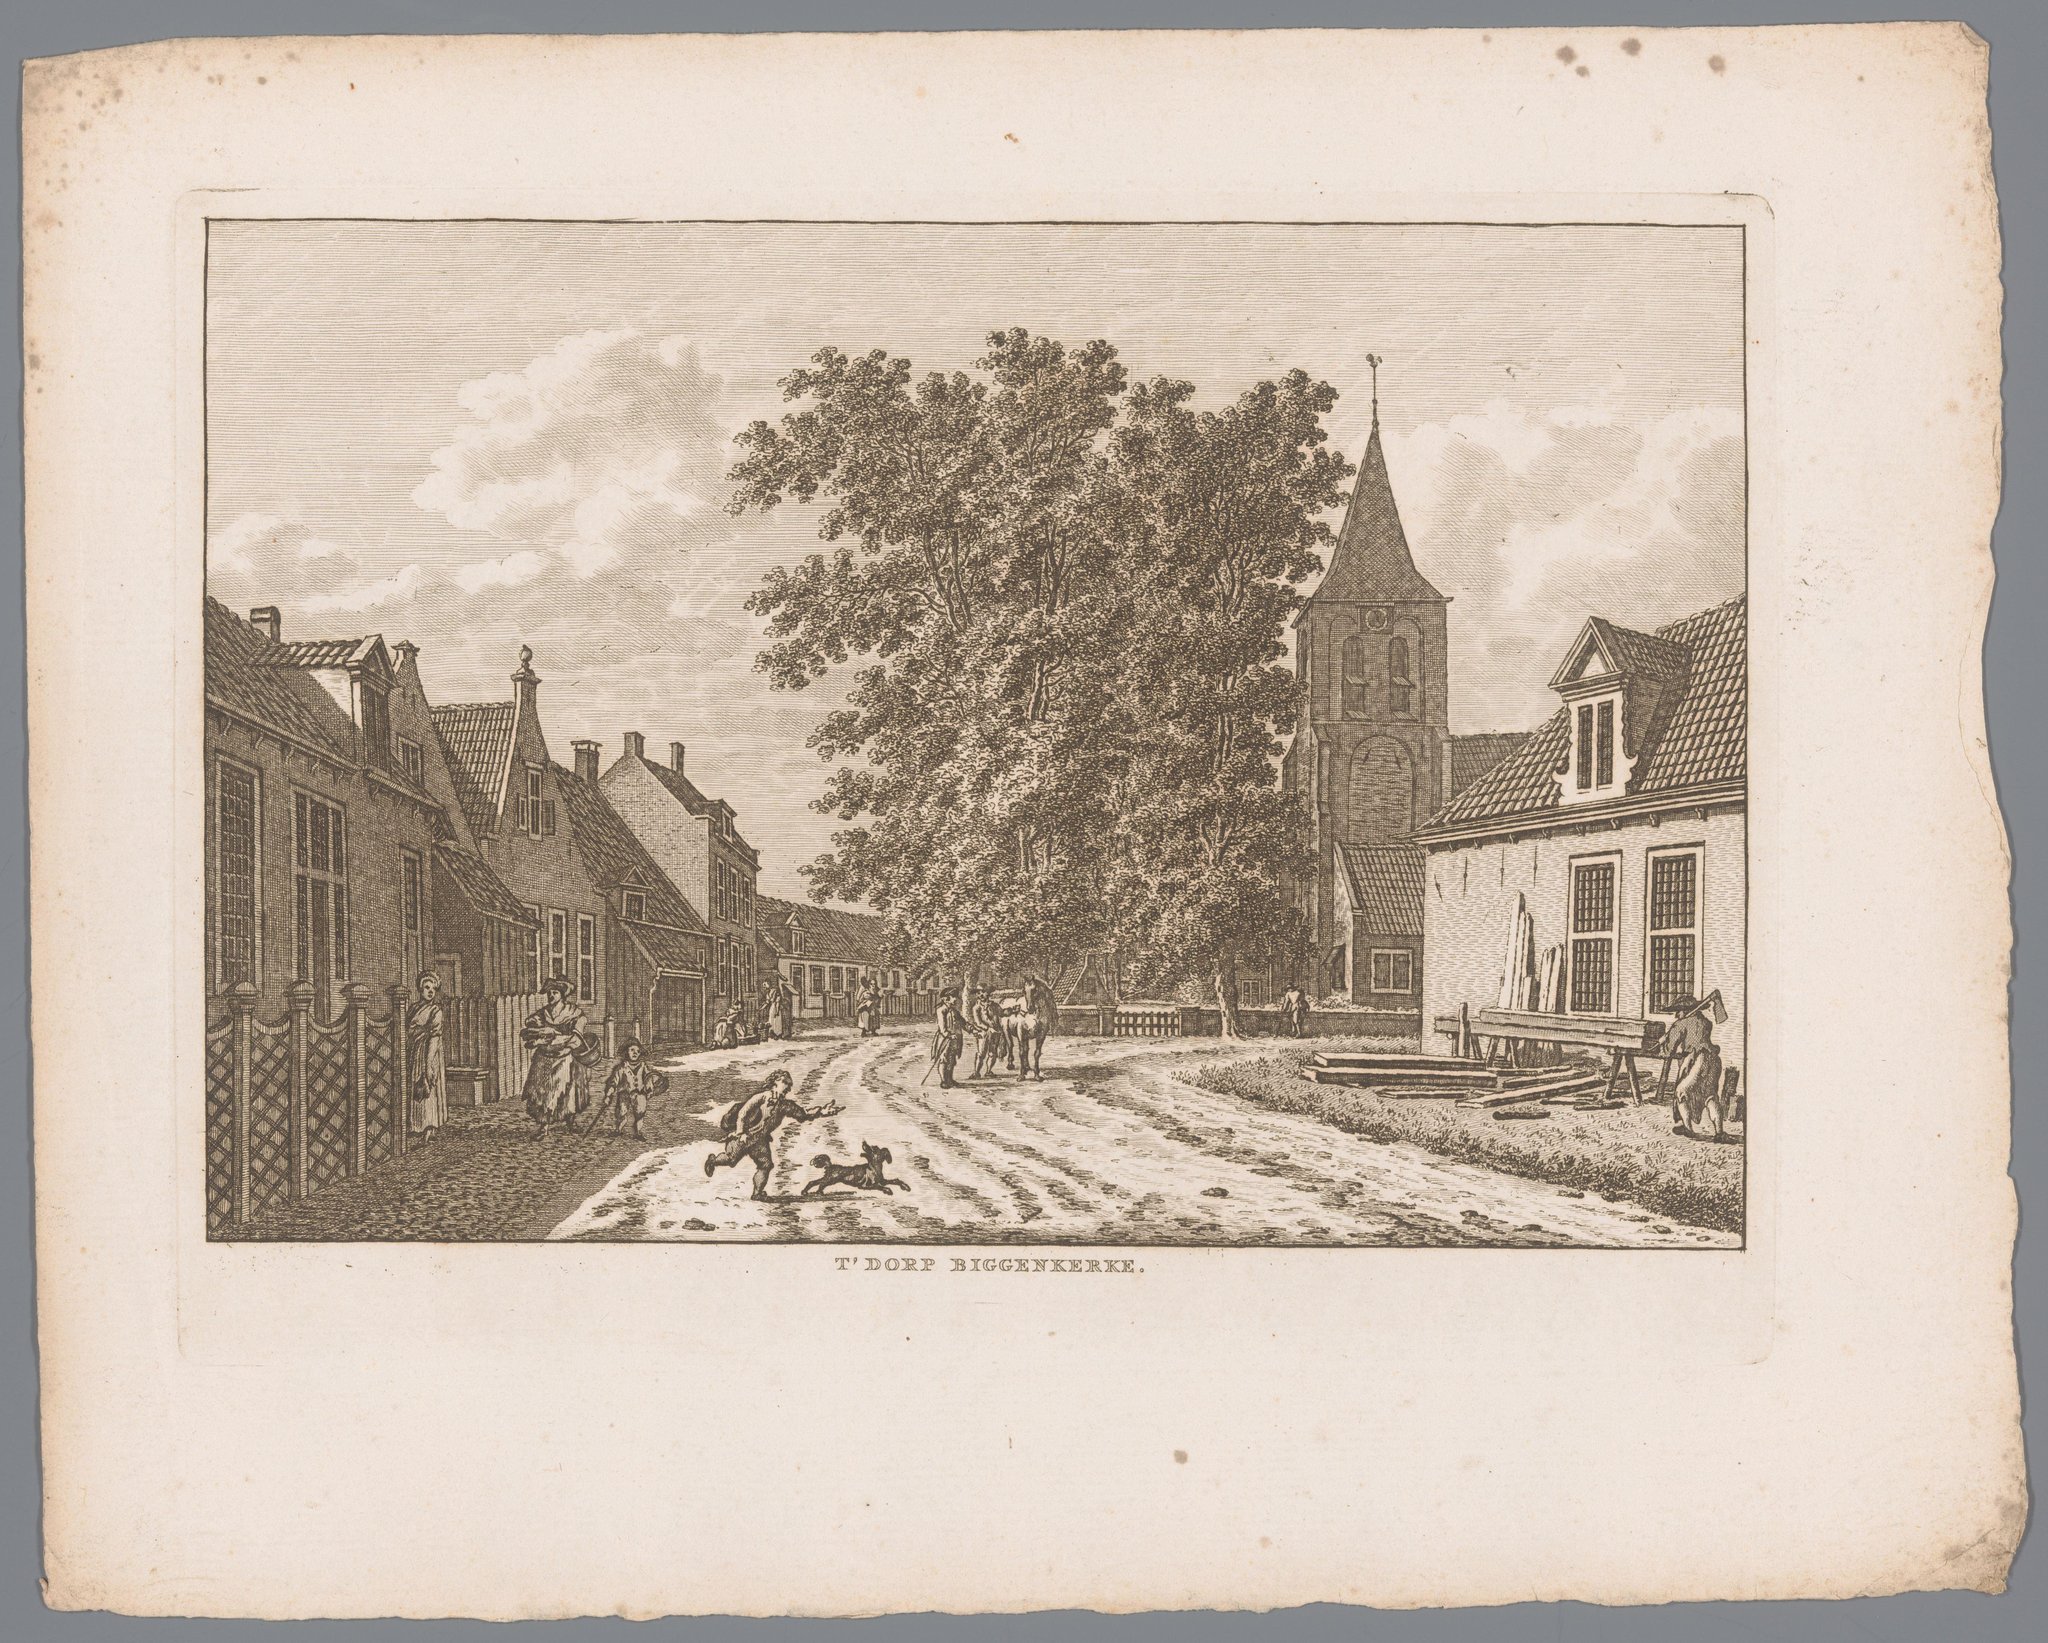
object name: print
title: Gezicht op Biggekerke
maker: carel frederik bendorp (i)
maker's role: print maker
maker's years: 1736-1814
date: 1786-1792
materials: paper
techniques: etching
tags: city-view, and landscape with man-made constructions, village street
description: Prent uit: Vaderlandsche gezichten, of afbeeldingen van den tegenwoordigen staat der Vereenigde Nederlanden (…). Amsterdam: Hendrik Gartman, Willem Vermandel en Jan Willem Smit, 1786-1792. Uitgegeven in afleveringen met ieder een eigen bifolium en inhoudsopgave. Alle prenten in deze publicatie zijn gegraveerd door Carel Frederik Bendorp (I) en, in de meeste gevallen, gebaseerd op tekeningen van Jan Bulthuis.